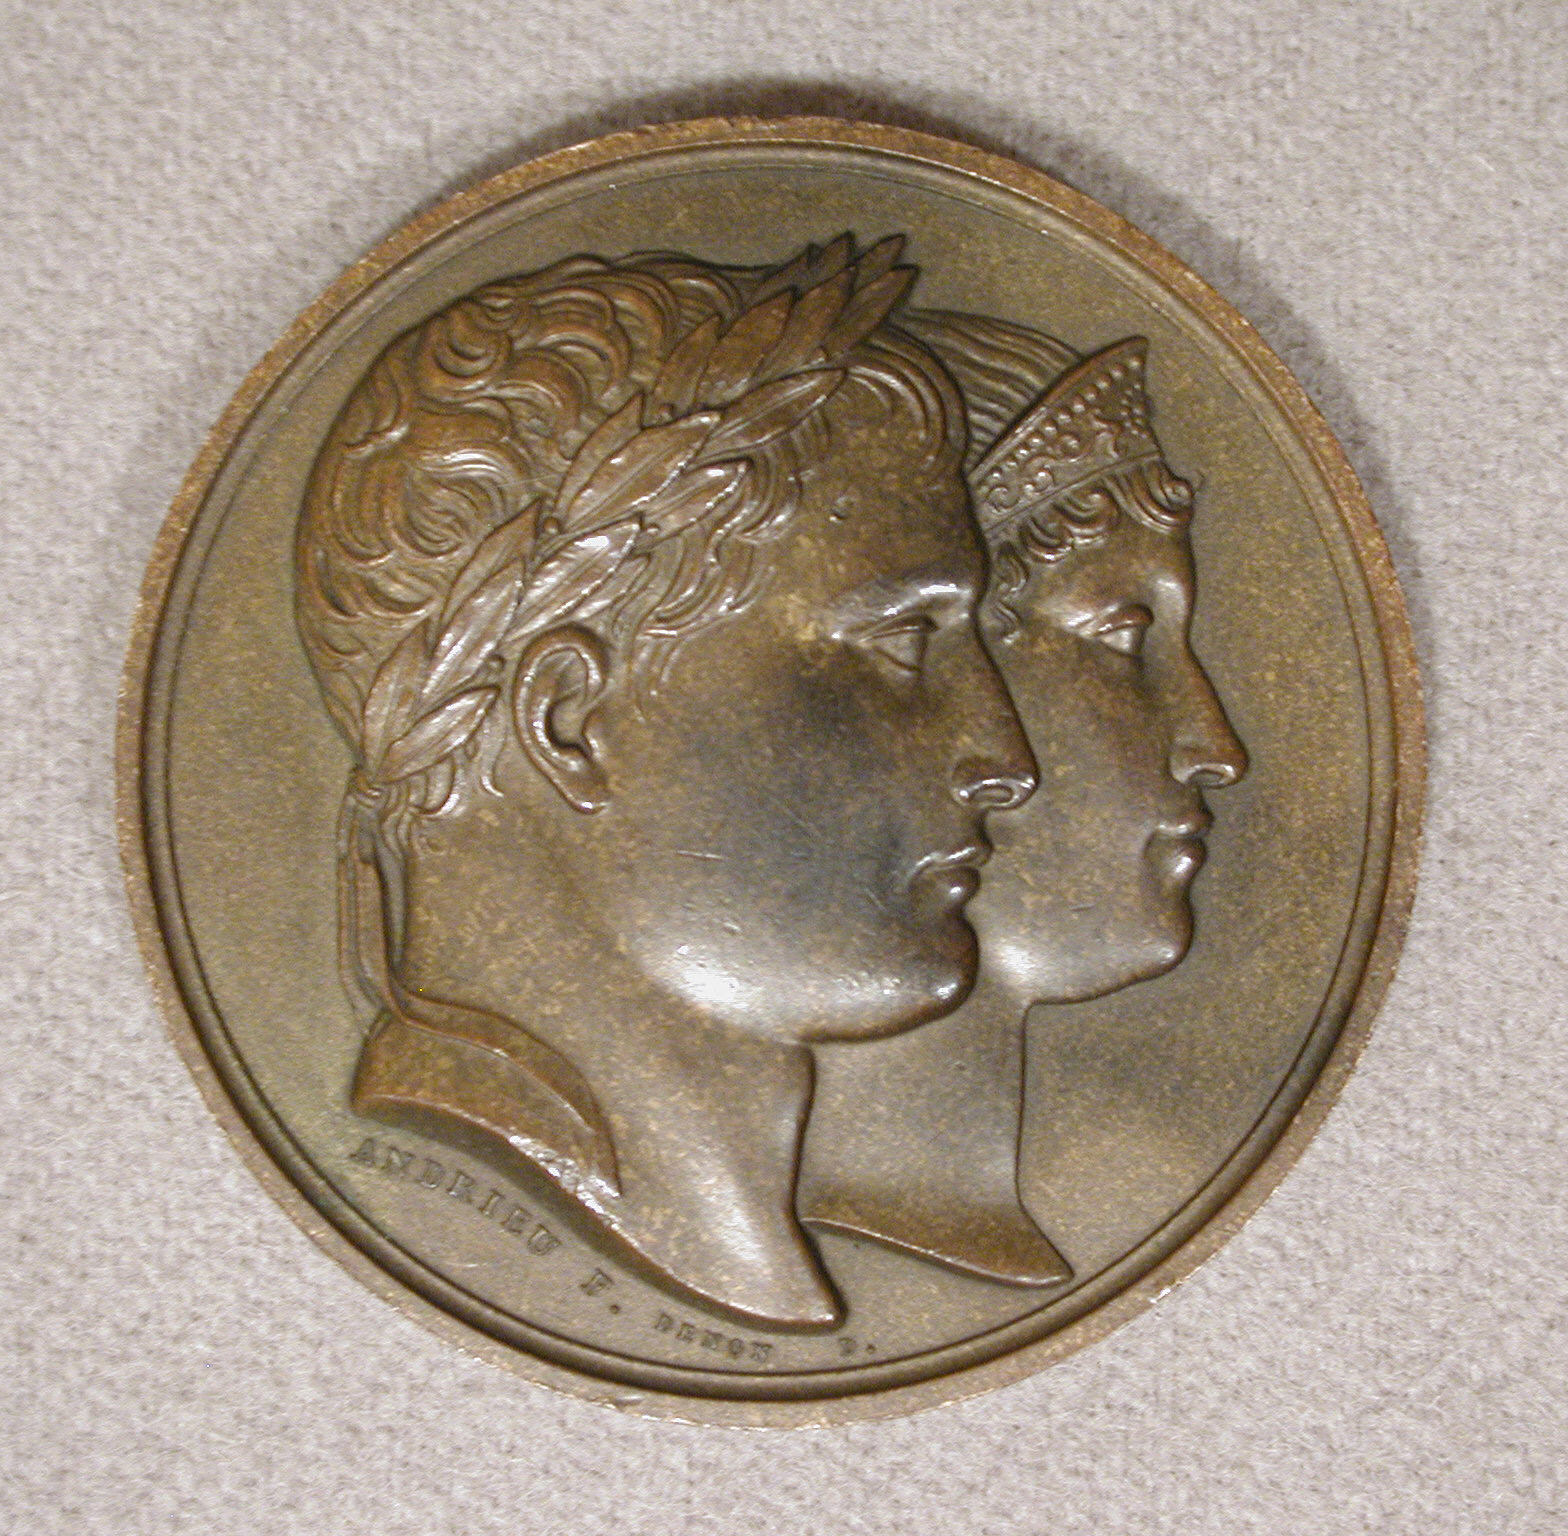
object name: medal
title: Marriage of Napoleon and Marie-Louise, April 1, 1810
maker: bertrand andrieu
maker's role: designer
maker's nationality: french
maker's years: 1761-1822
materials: bronze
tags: men,profiles,women